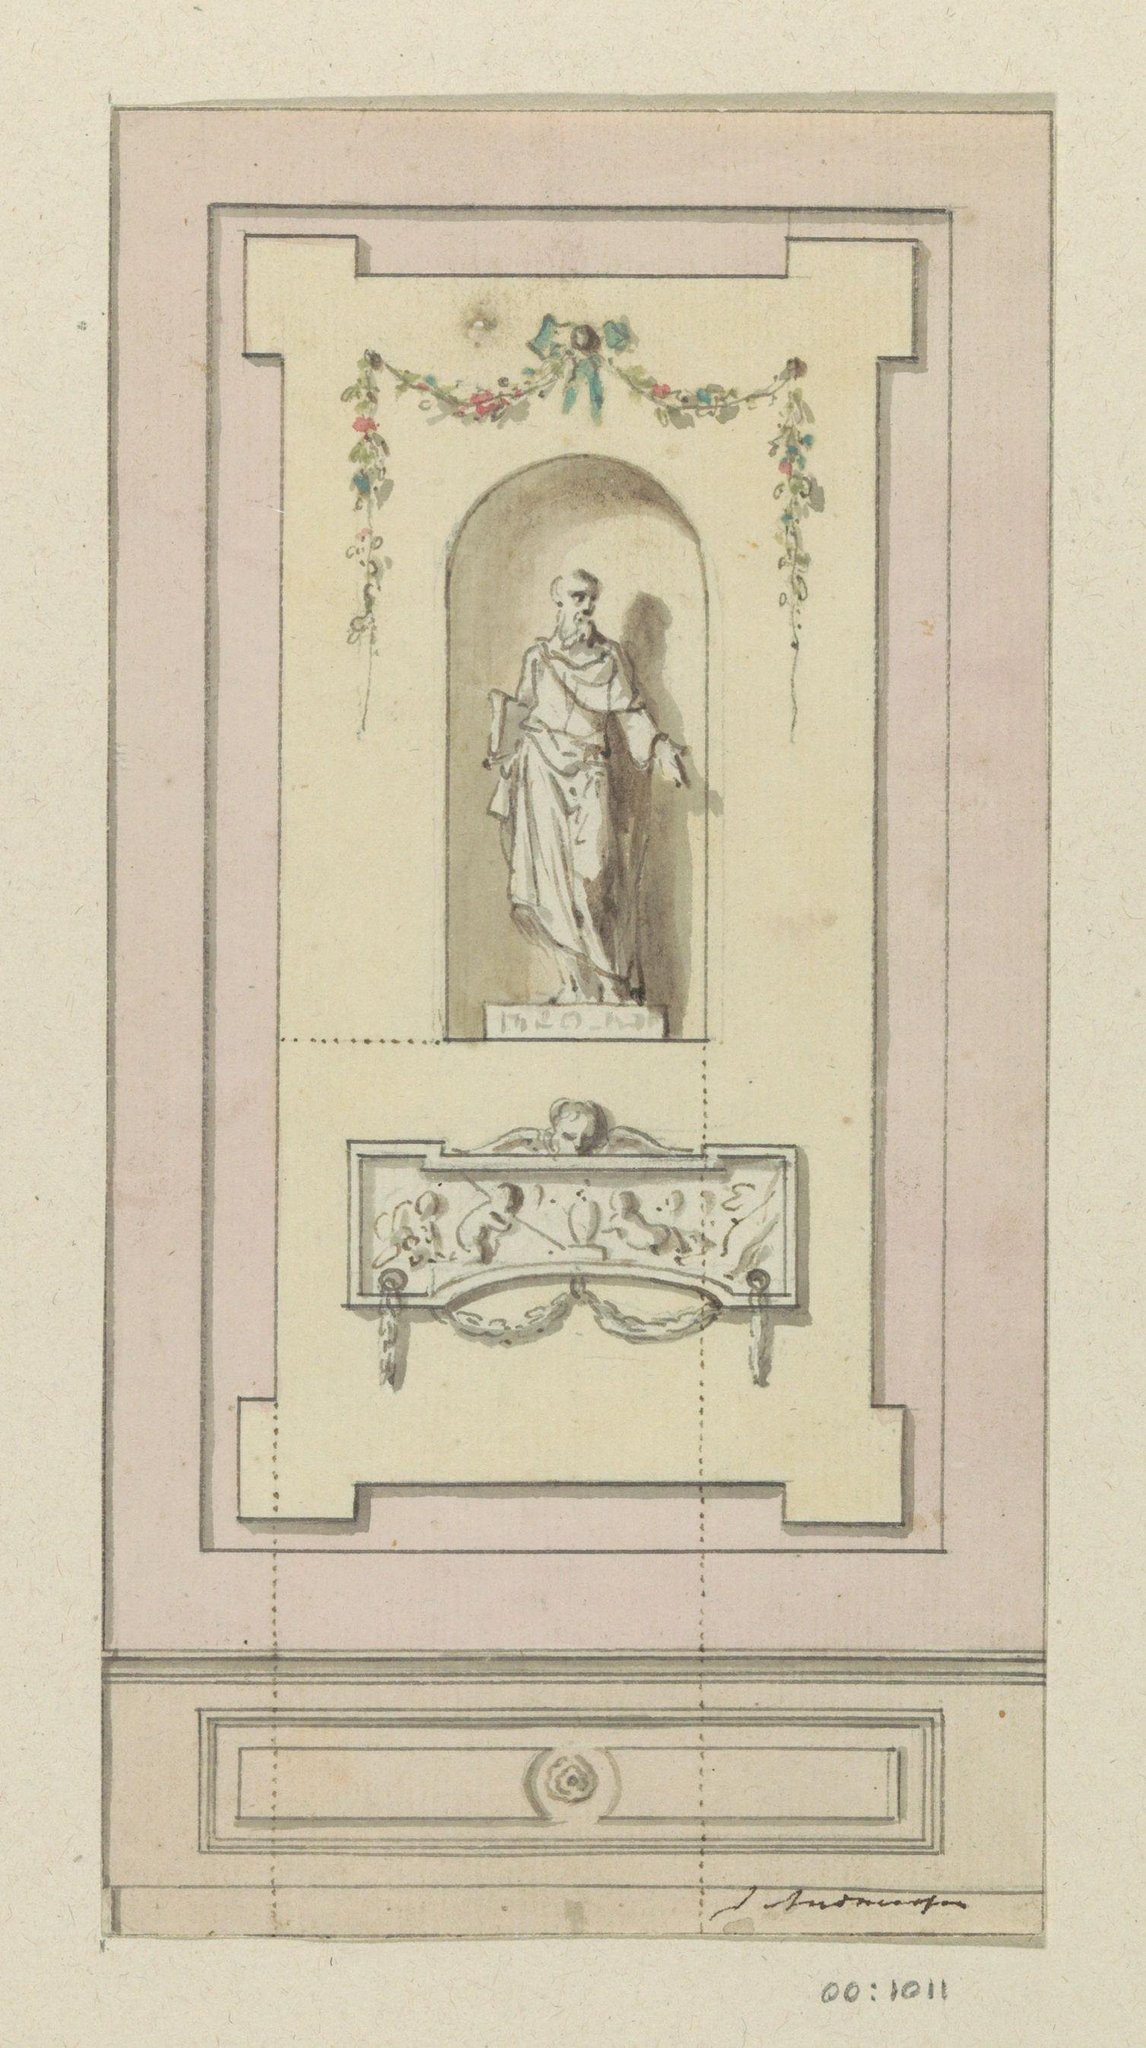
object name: drawing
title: Ontwerptekening voor een kamerwand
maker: jurriaan andriessen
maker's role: draughtsman, painter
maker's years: 1742-1819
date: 1760-1819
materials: paint, paper, pencil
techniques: brush, pen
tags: sculpture, wall-covering, cupids: 'amores', 'amoretti', 'putti'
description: Met een sculptuur in een nis, met daarboven een guirlande en daaronder een decoratie met putti. Tekening maakt deel uit van een album.